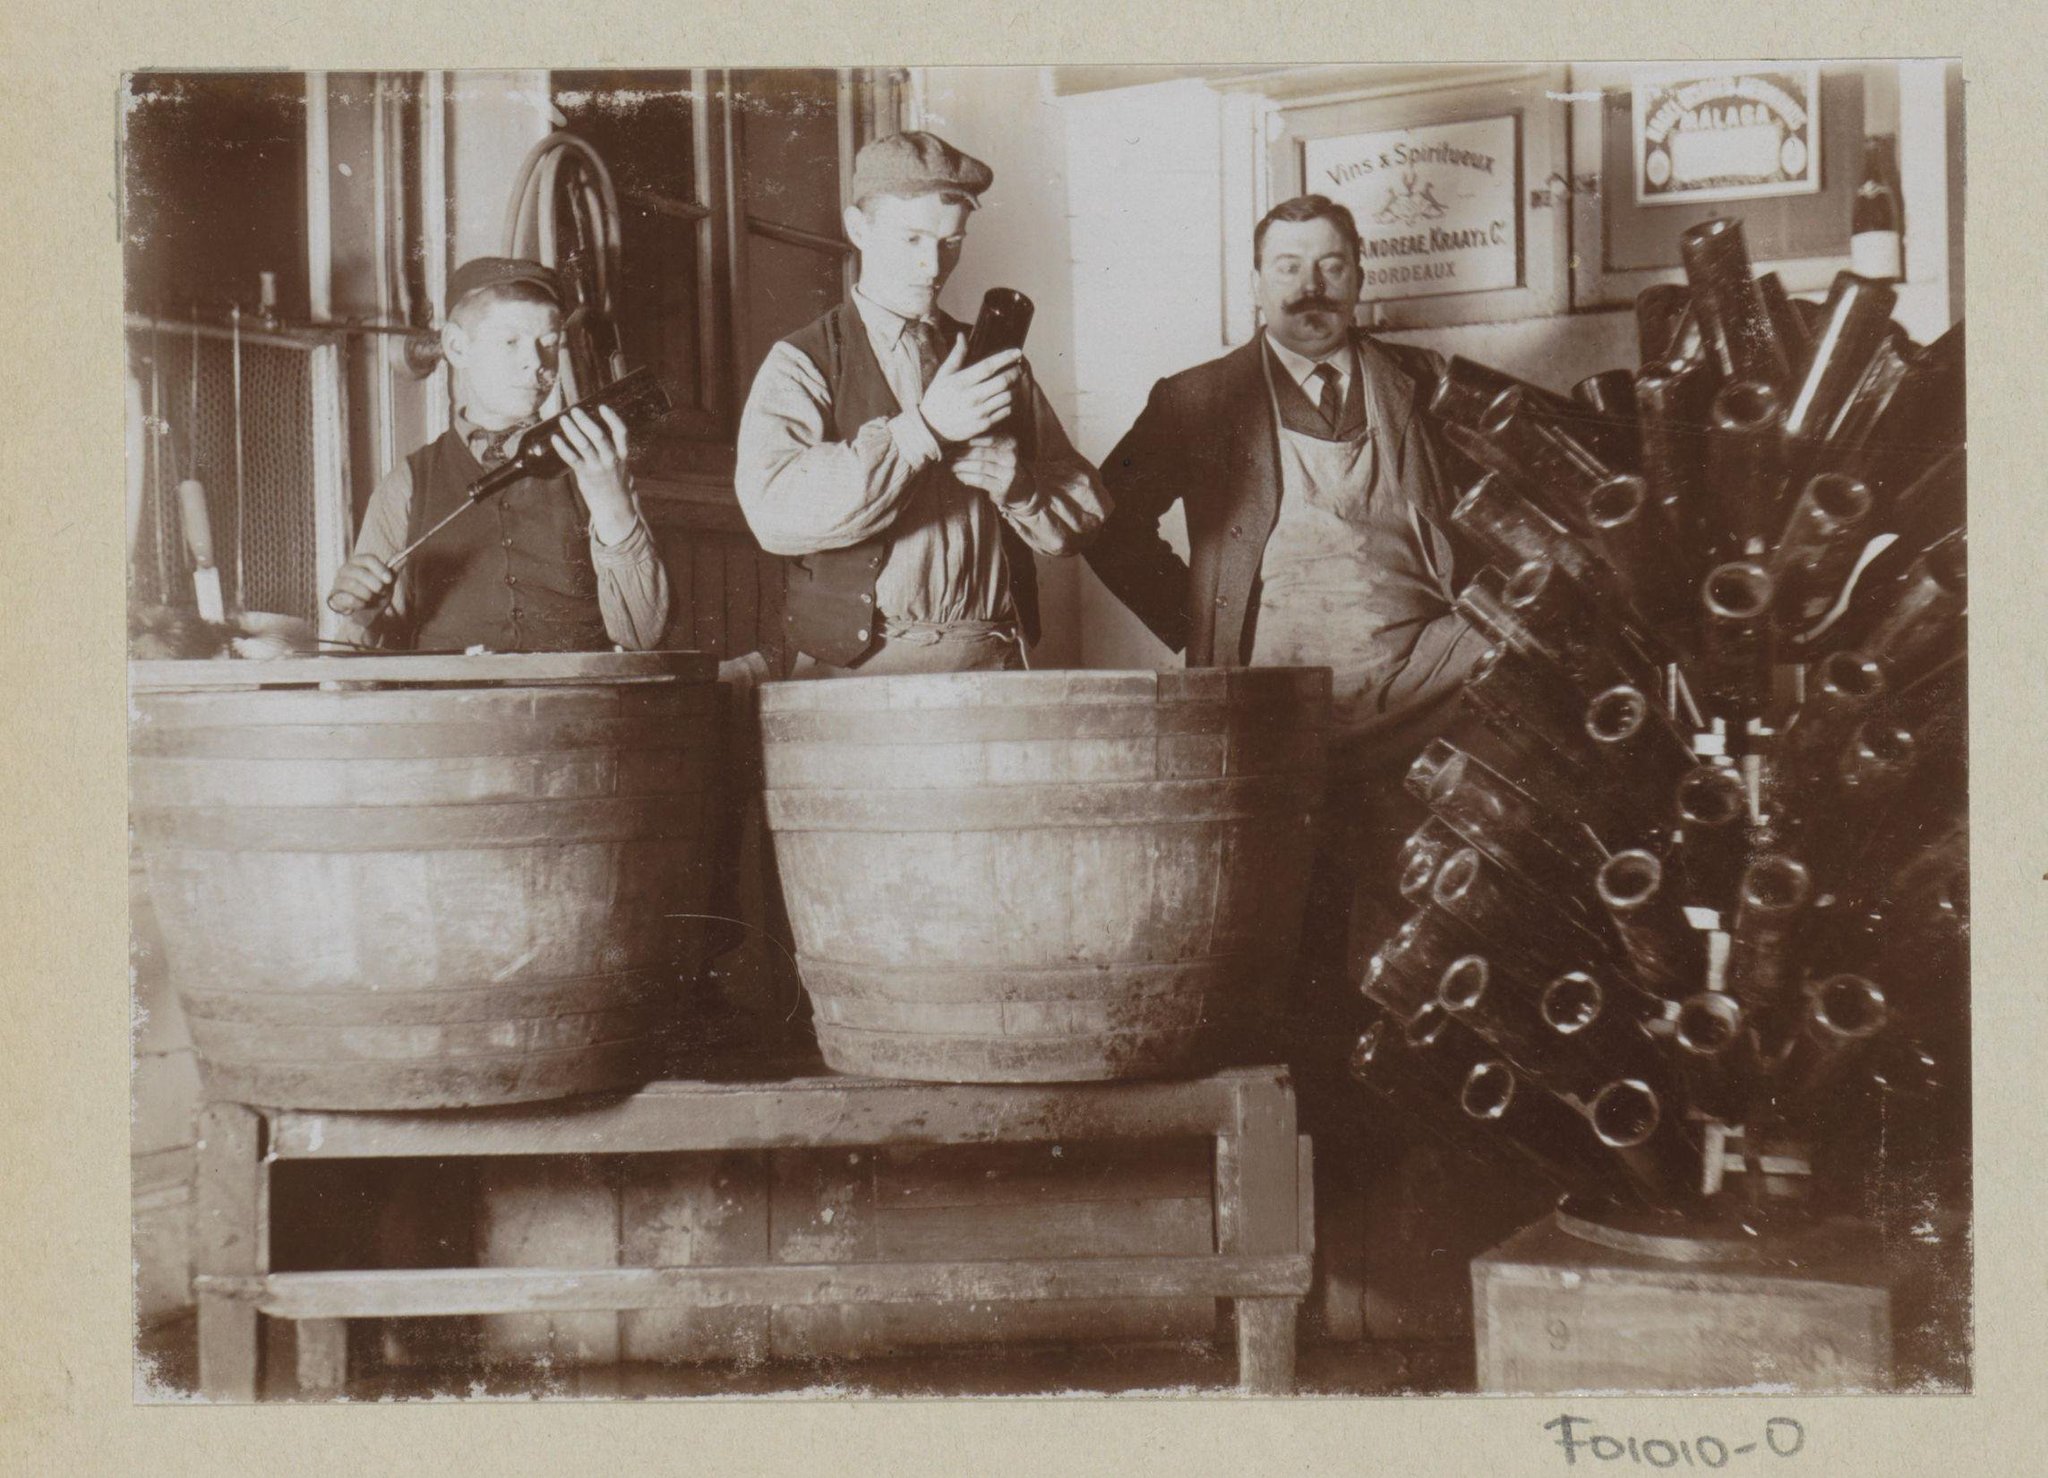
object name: photograph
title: Brouwer en bedienden reinigen flessen bij een flessendroogrek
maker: Anonymous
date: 1900-1910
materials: photographic support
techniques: collodion silver print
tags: wooden container: barrel, cask (+ wood and other phytogenic material), bottling of wine (+ men (labourers))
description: Onderdeel van Familiealbum met onder meer foto's van Wijnhandel Kraaij & Co. Bordeaux-Amsterdam.